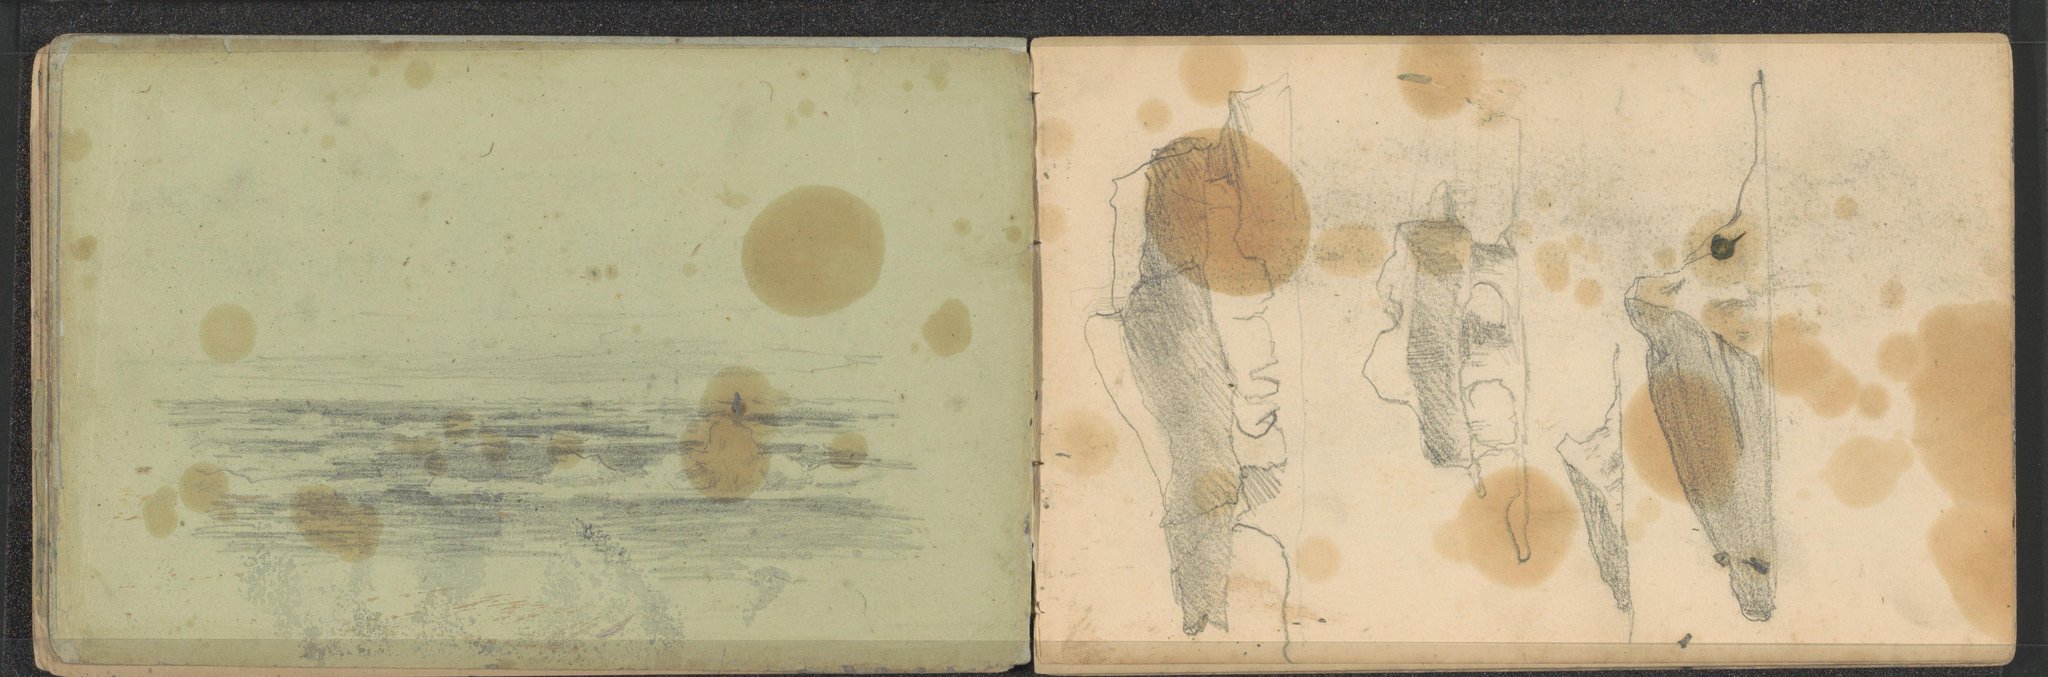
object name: sketchbook leaf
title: Gezicht op de Barentszzee met ijsschotsen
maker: louis apol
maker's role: draughtsman, painter, print maker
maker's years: 1850-1936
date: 1880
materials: paper, pencil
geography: barentsz sea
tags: sea (seascape), drift ice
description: Blad 25 verso uit een schetsboek met 35 bladen betekend tijdens de expeditie naar Nova Zembla in 1880.